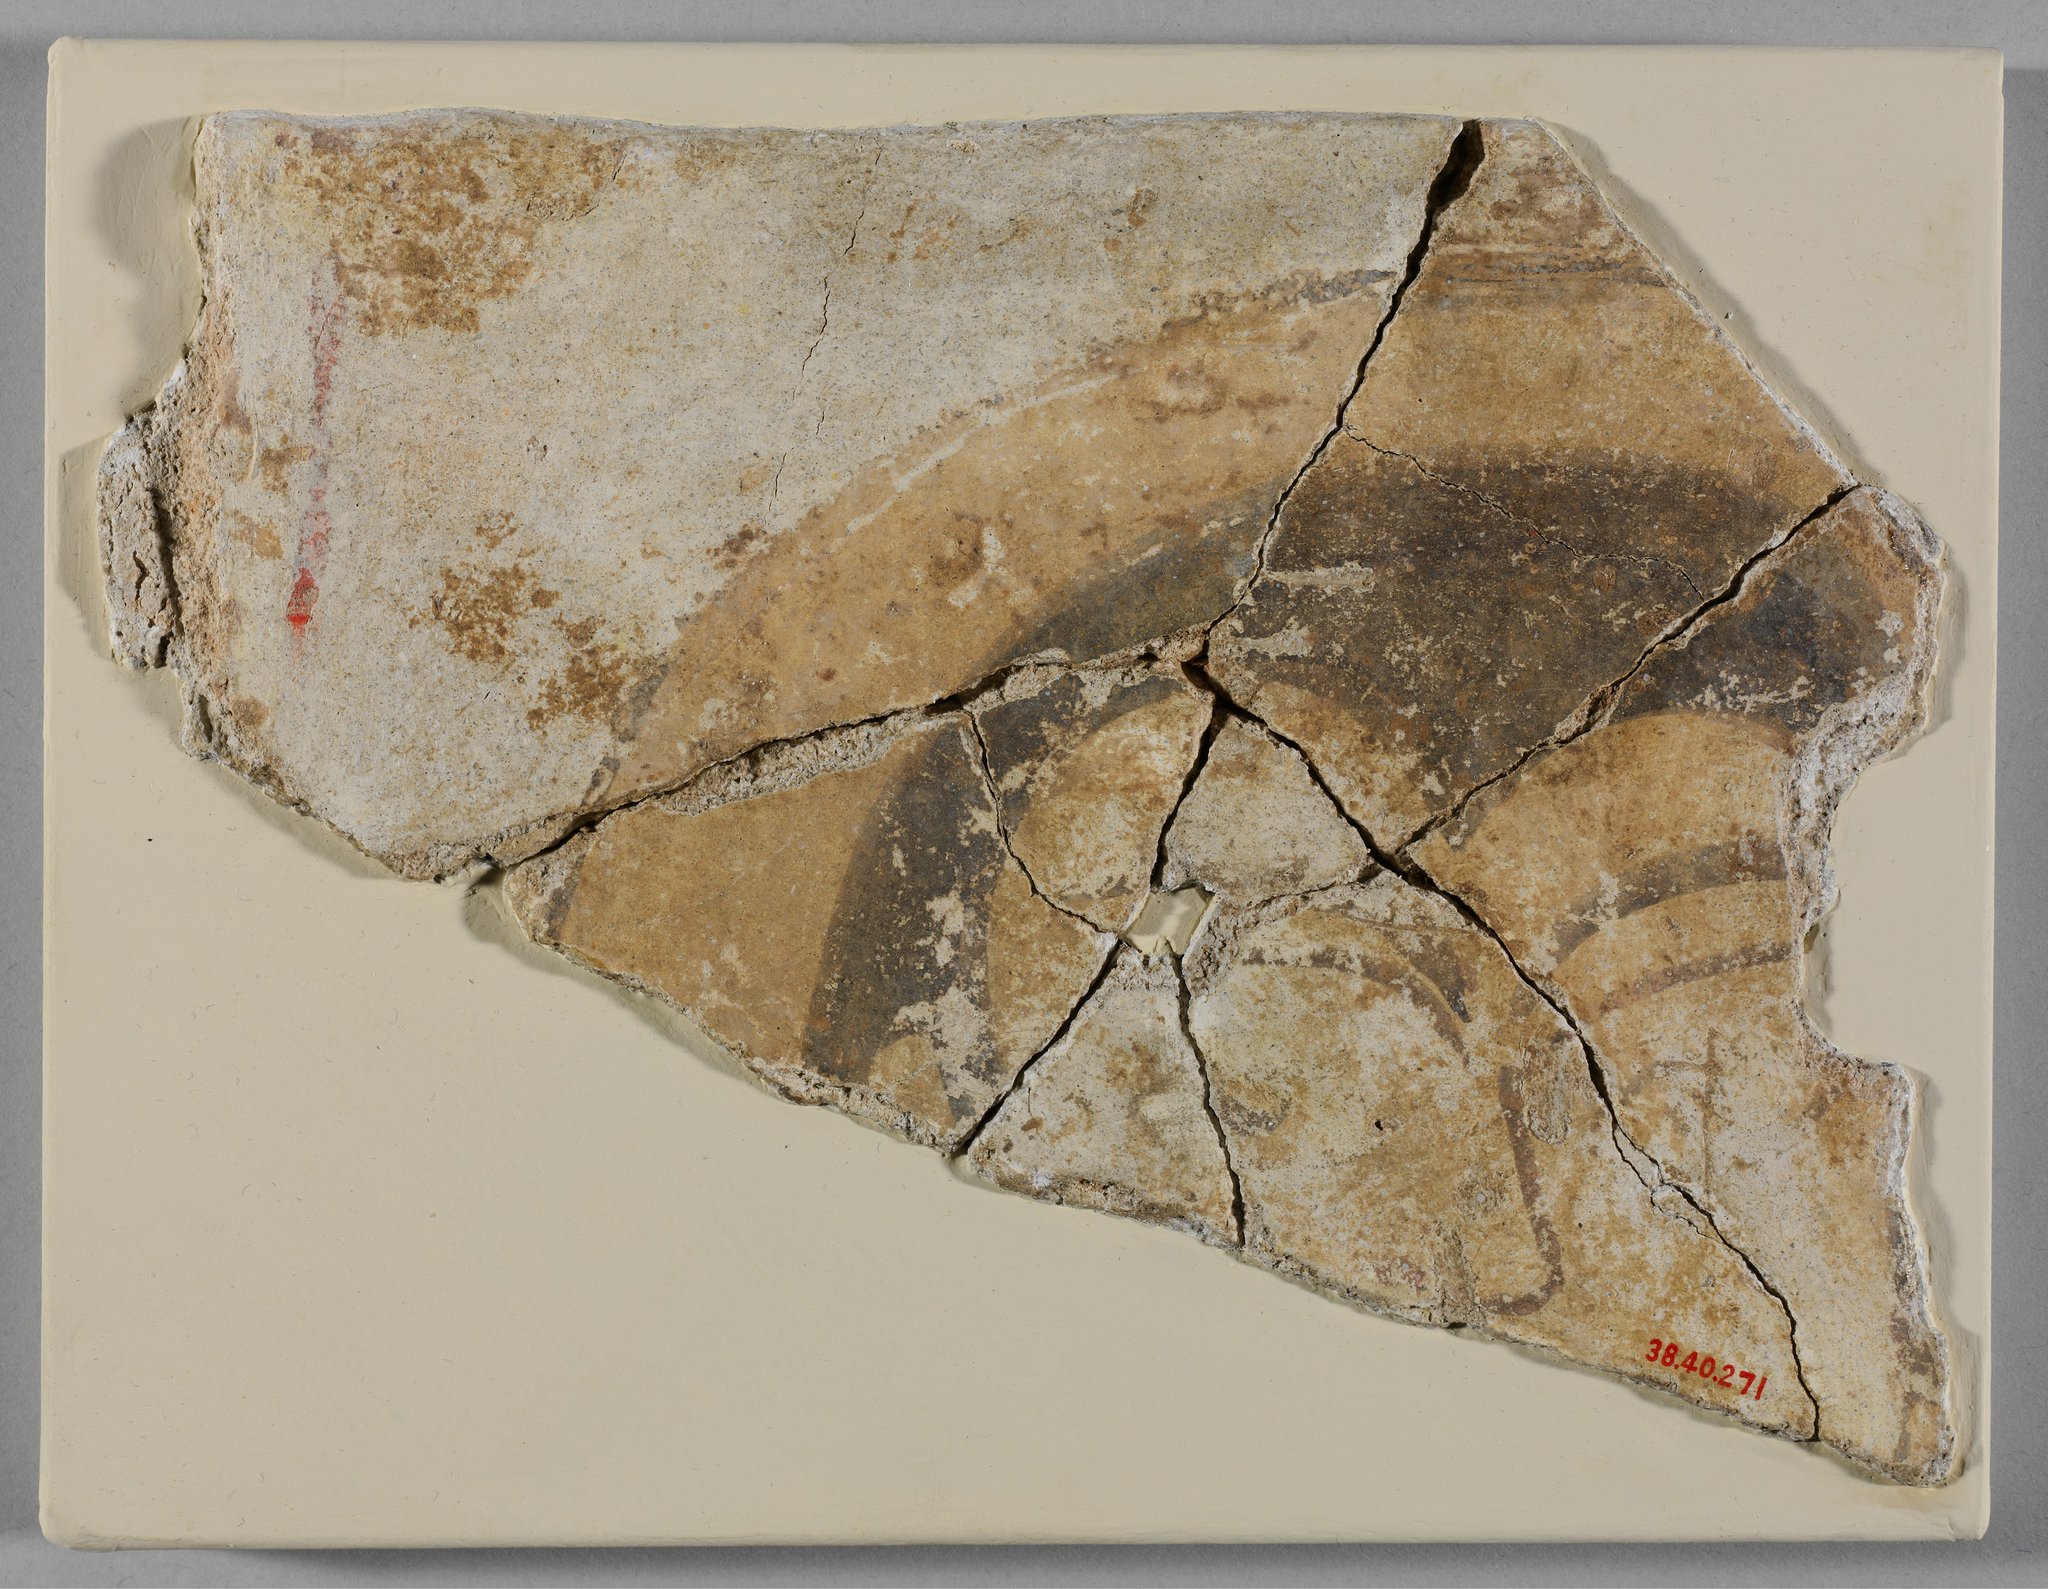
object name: wall painting fragment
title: Man with Black Hair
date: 801-1000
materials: plaster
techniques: painting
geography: iran